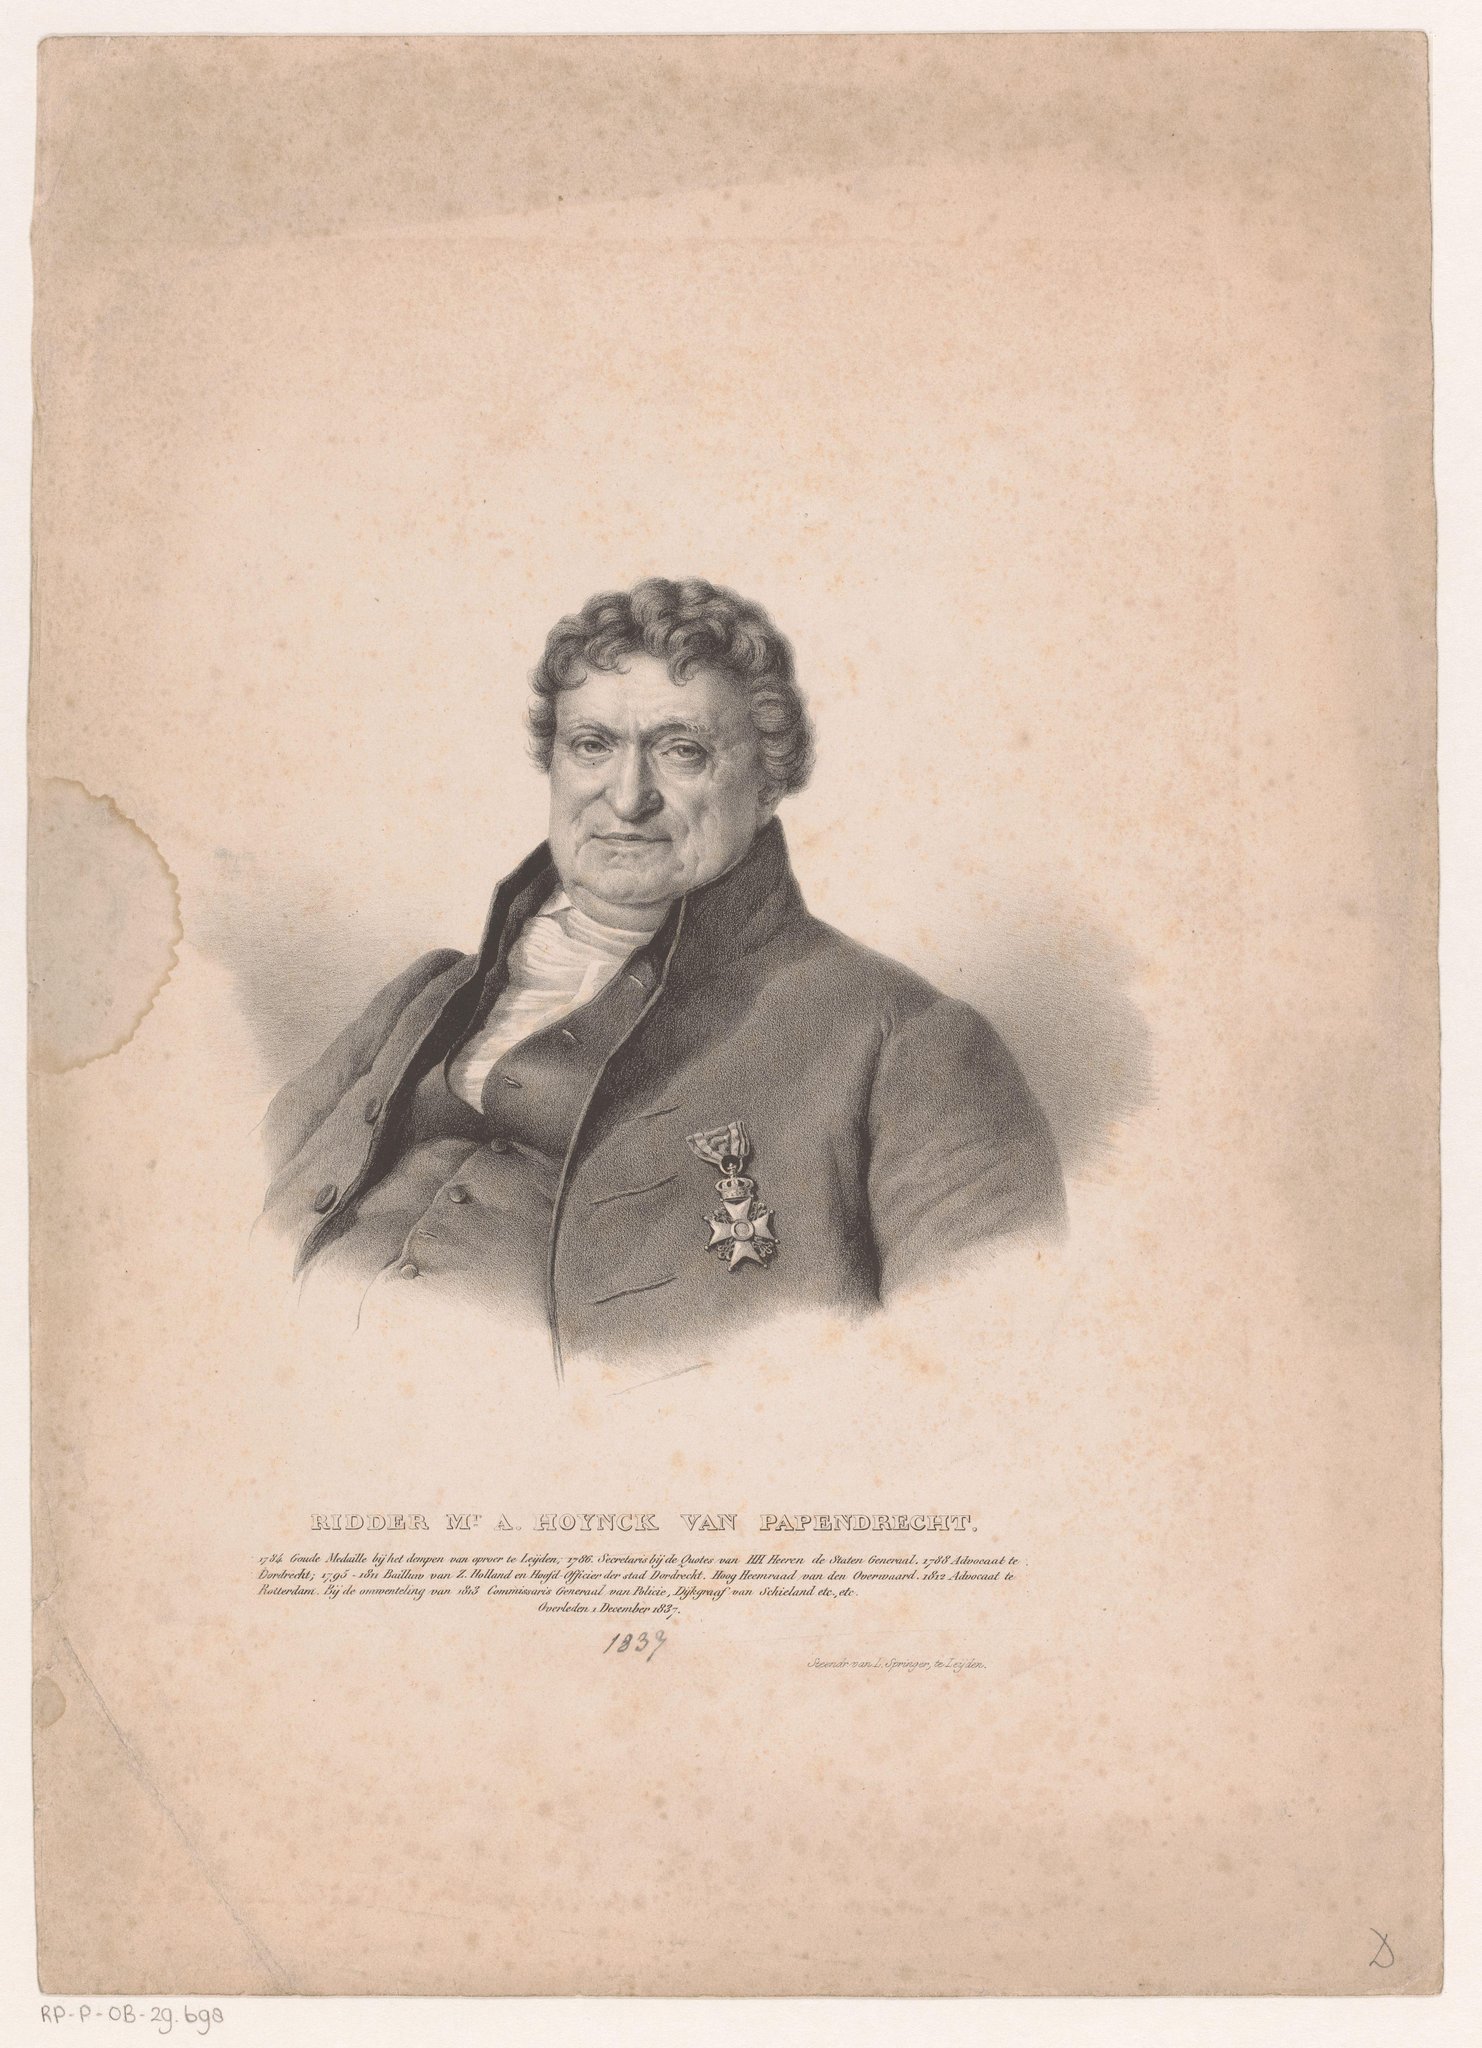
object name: print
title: Portret van Anthony Hoynck van Papendrecht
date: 1809-1853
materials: paper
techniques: lithograph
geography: leiden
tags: historical persons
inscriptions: collector's mark: Lugt 2228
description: Onder het portret de biografische gegevens van de geportretteerde.